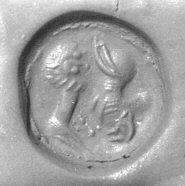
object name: stamp seal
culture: sasanian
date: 201-700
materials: stone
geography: iran or mesopotamia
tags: animals